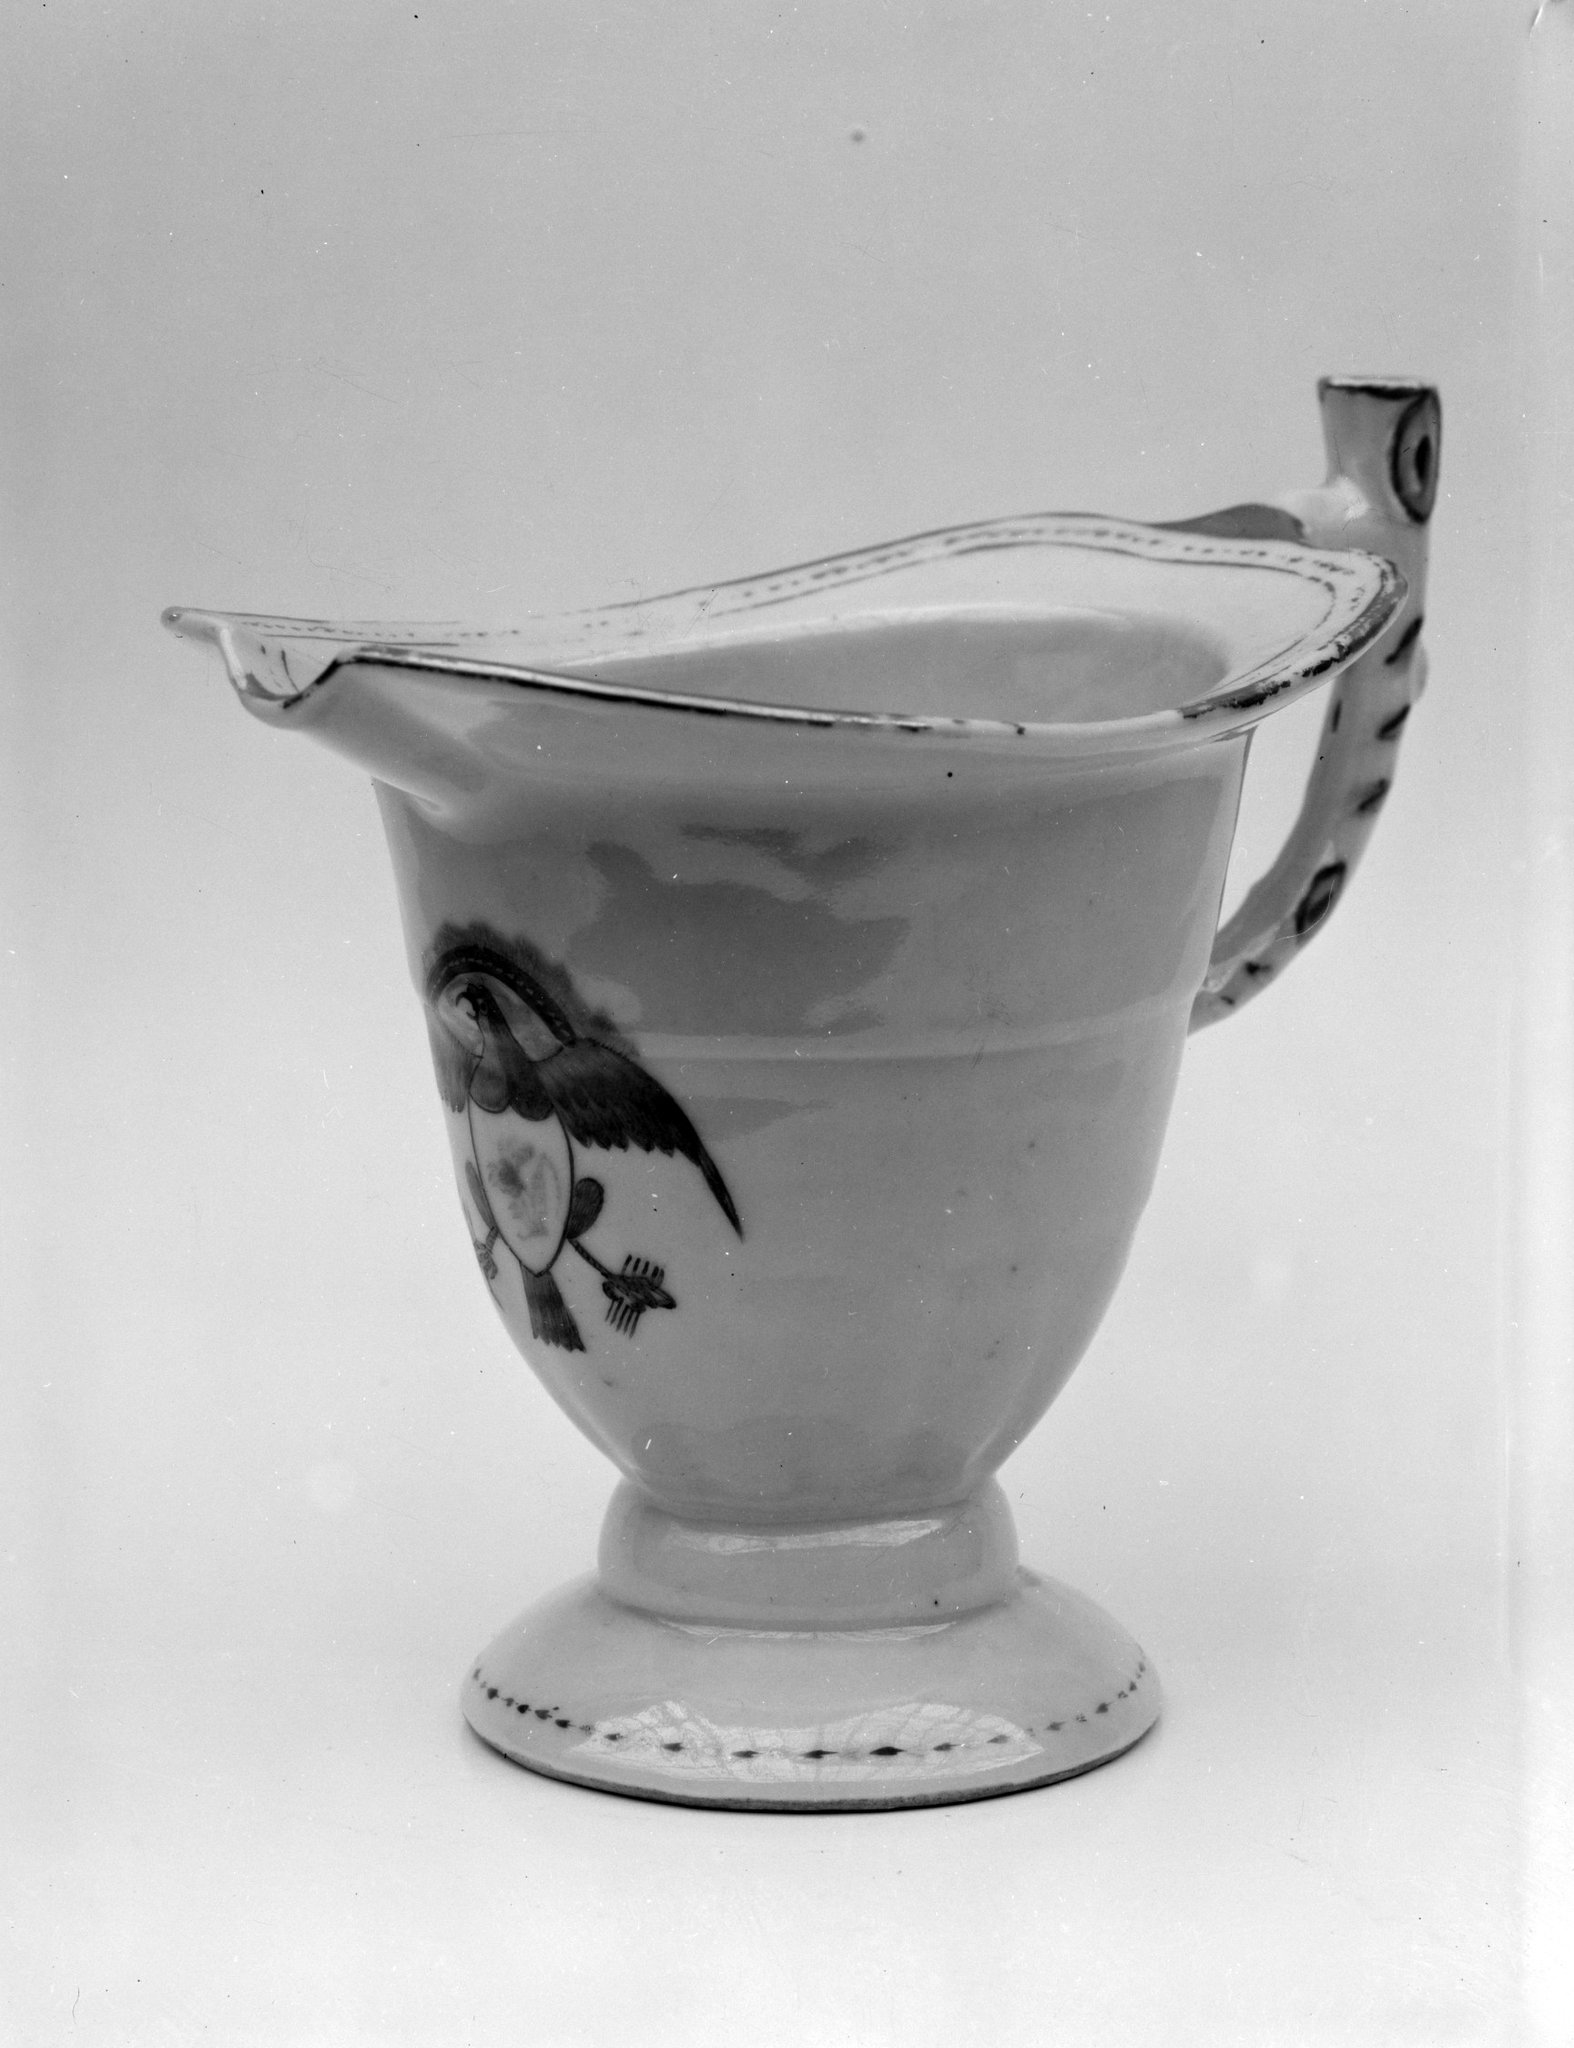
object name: cream pot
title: Creamer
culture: chinese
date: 1800-1815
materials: porcelain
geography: china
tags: eagles